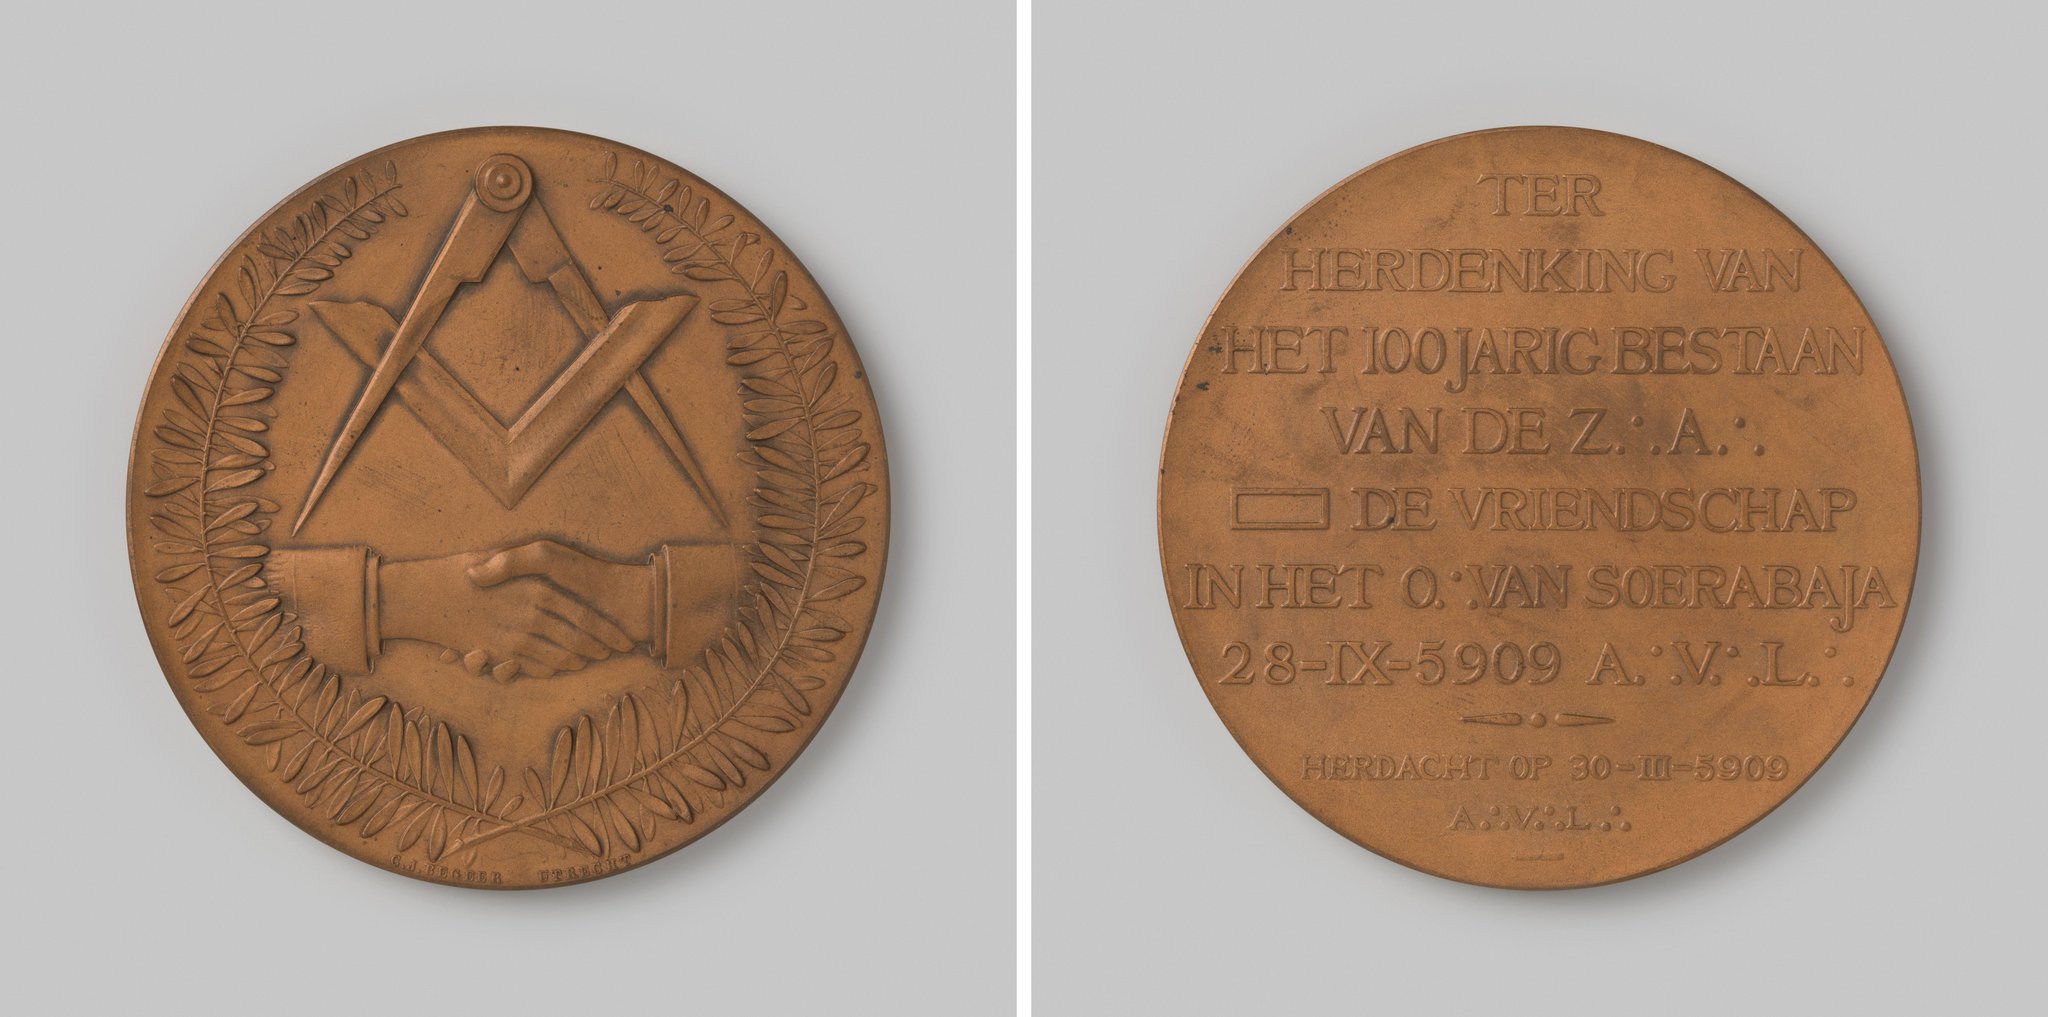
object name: history medal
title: Honderdjarig bestaan van loge De Vriendschap te Soerabaja 1909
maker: johan august dal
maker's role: medailleur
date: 1909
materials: bronze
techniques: striking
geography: utrecht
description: Bronzen penning, op de voorzijde een passer en tekenhaak boven twee ineengeslagen handen, tussen twee takken, op de keerzijde negen regels tekst.